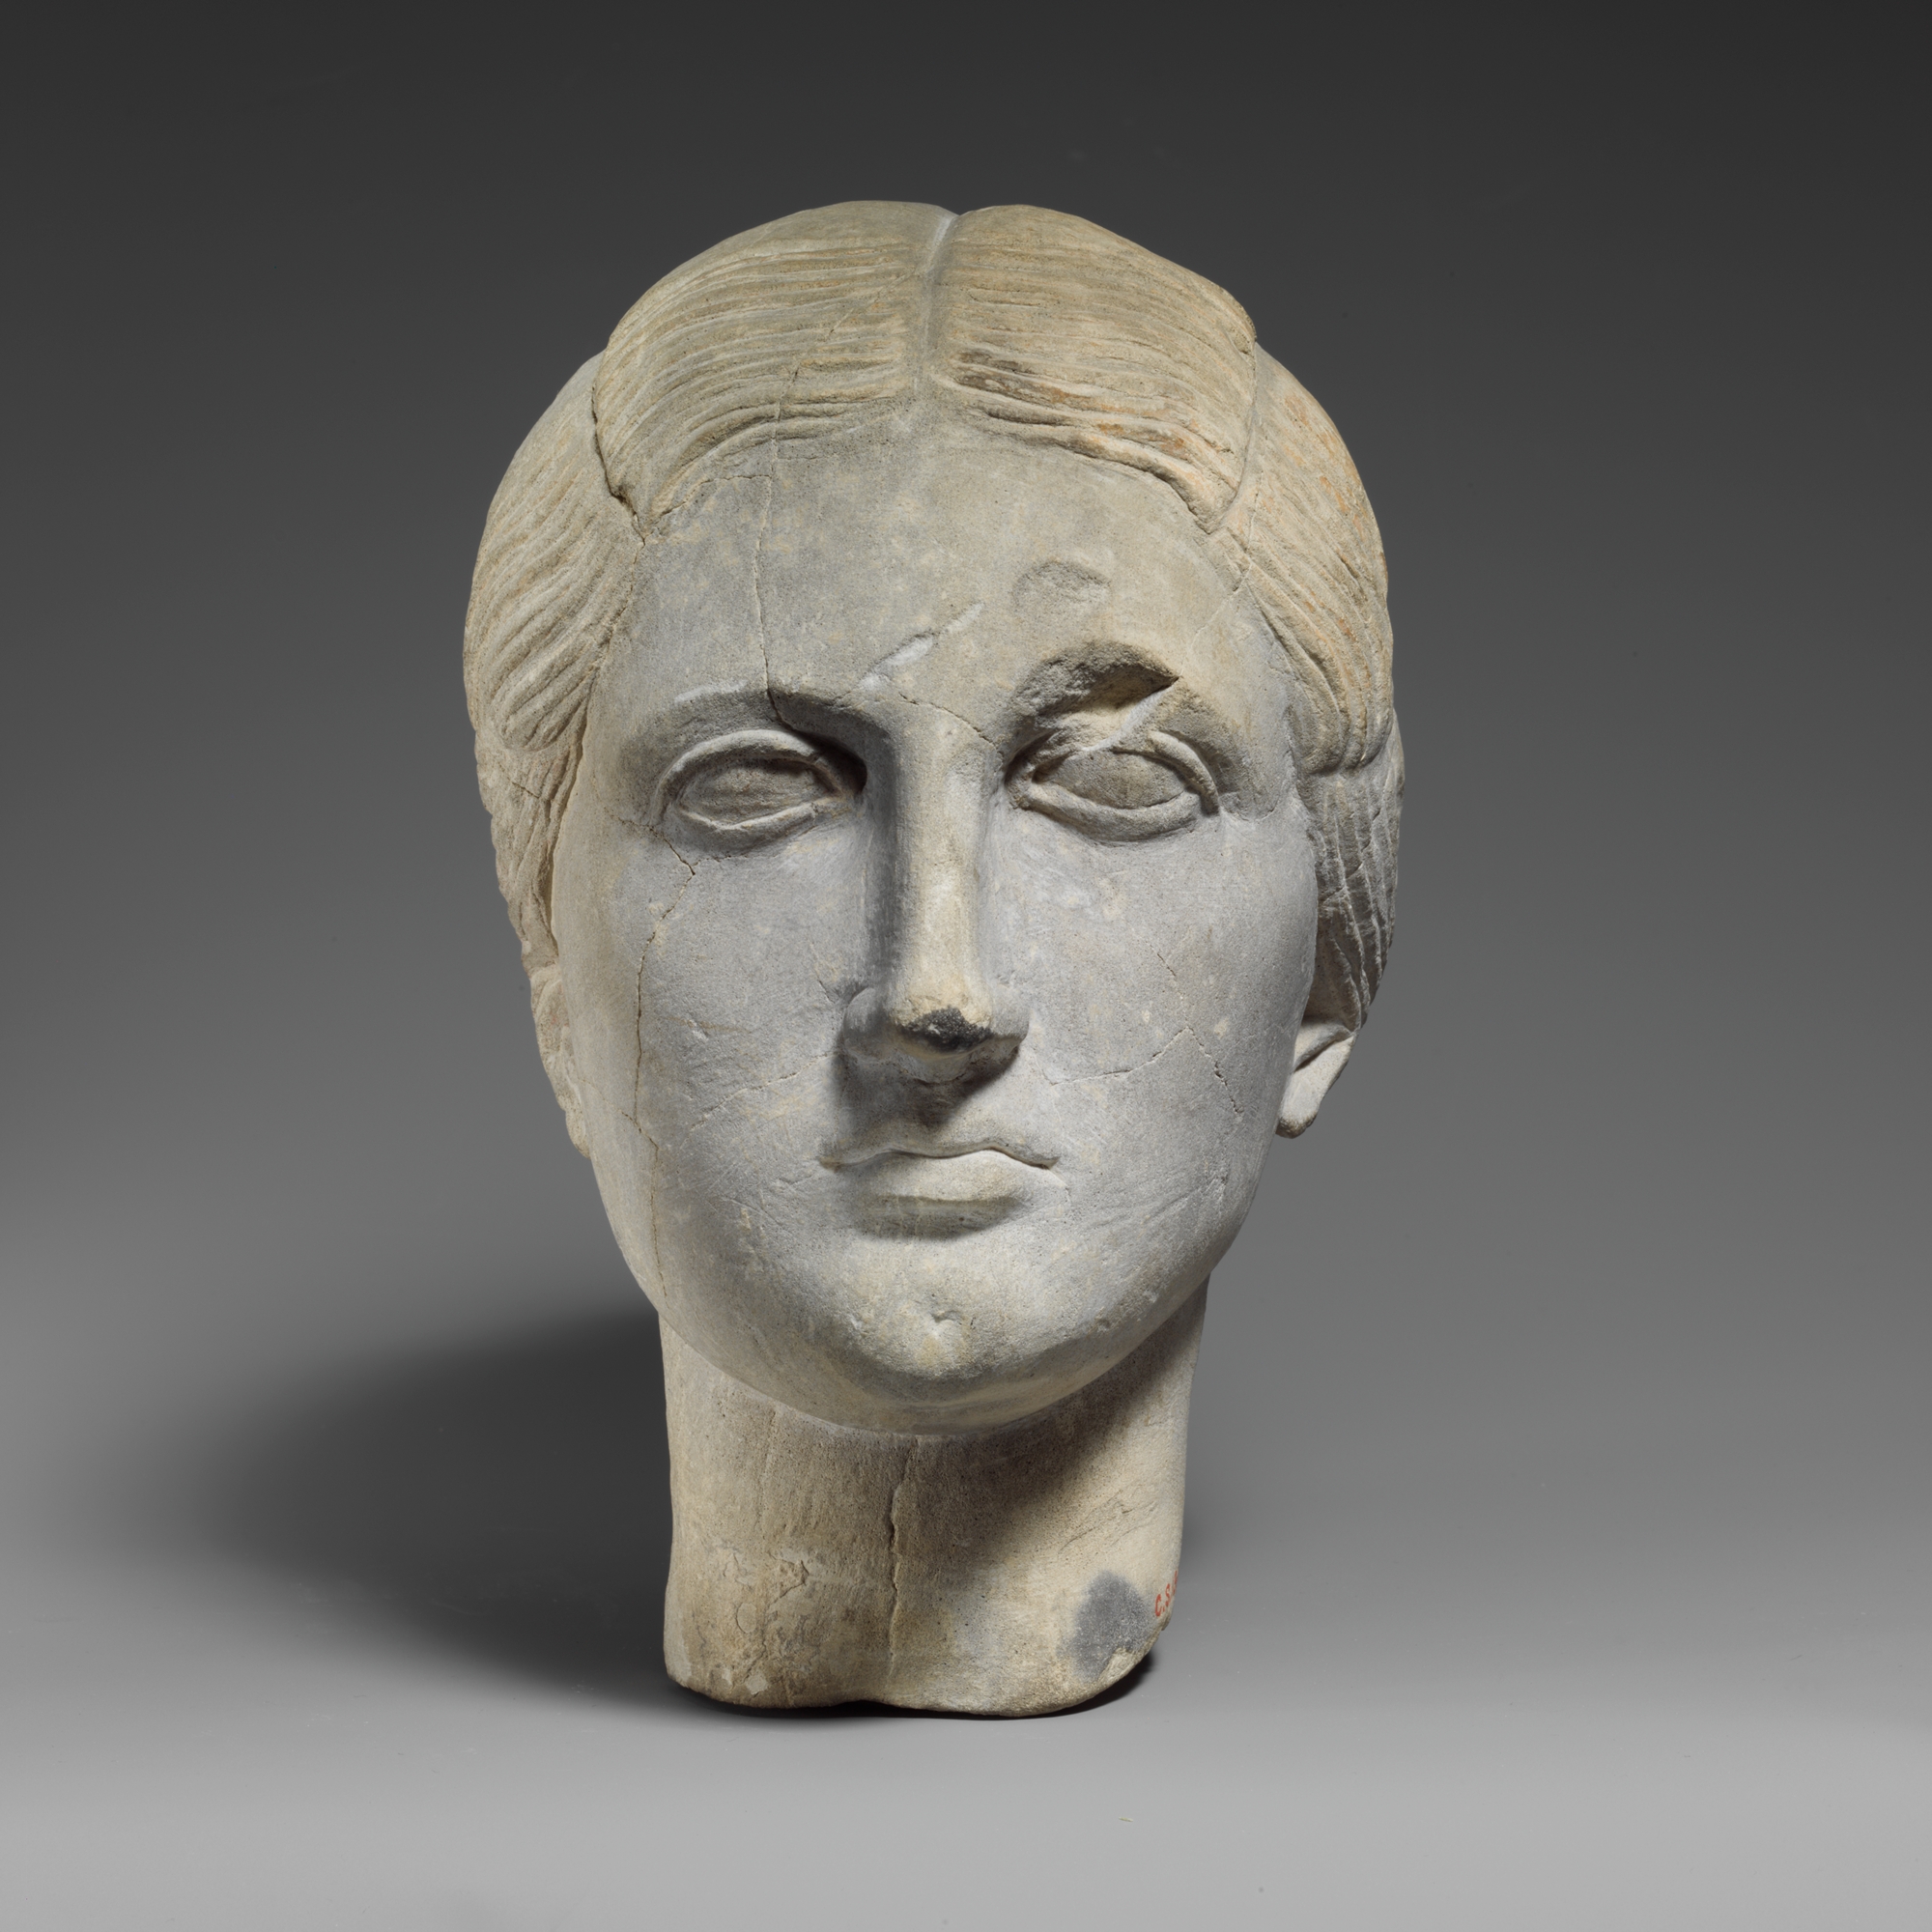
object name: portrait head of a woman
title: Limestone funerary bust of a woman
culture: cypriot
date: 3900 BCE-100 CE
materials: limestone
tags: women